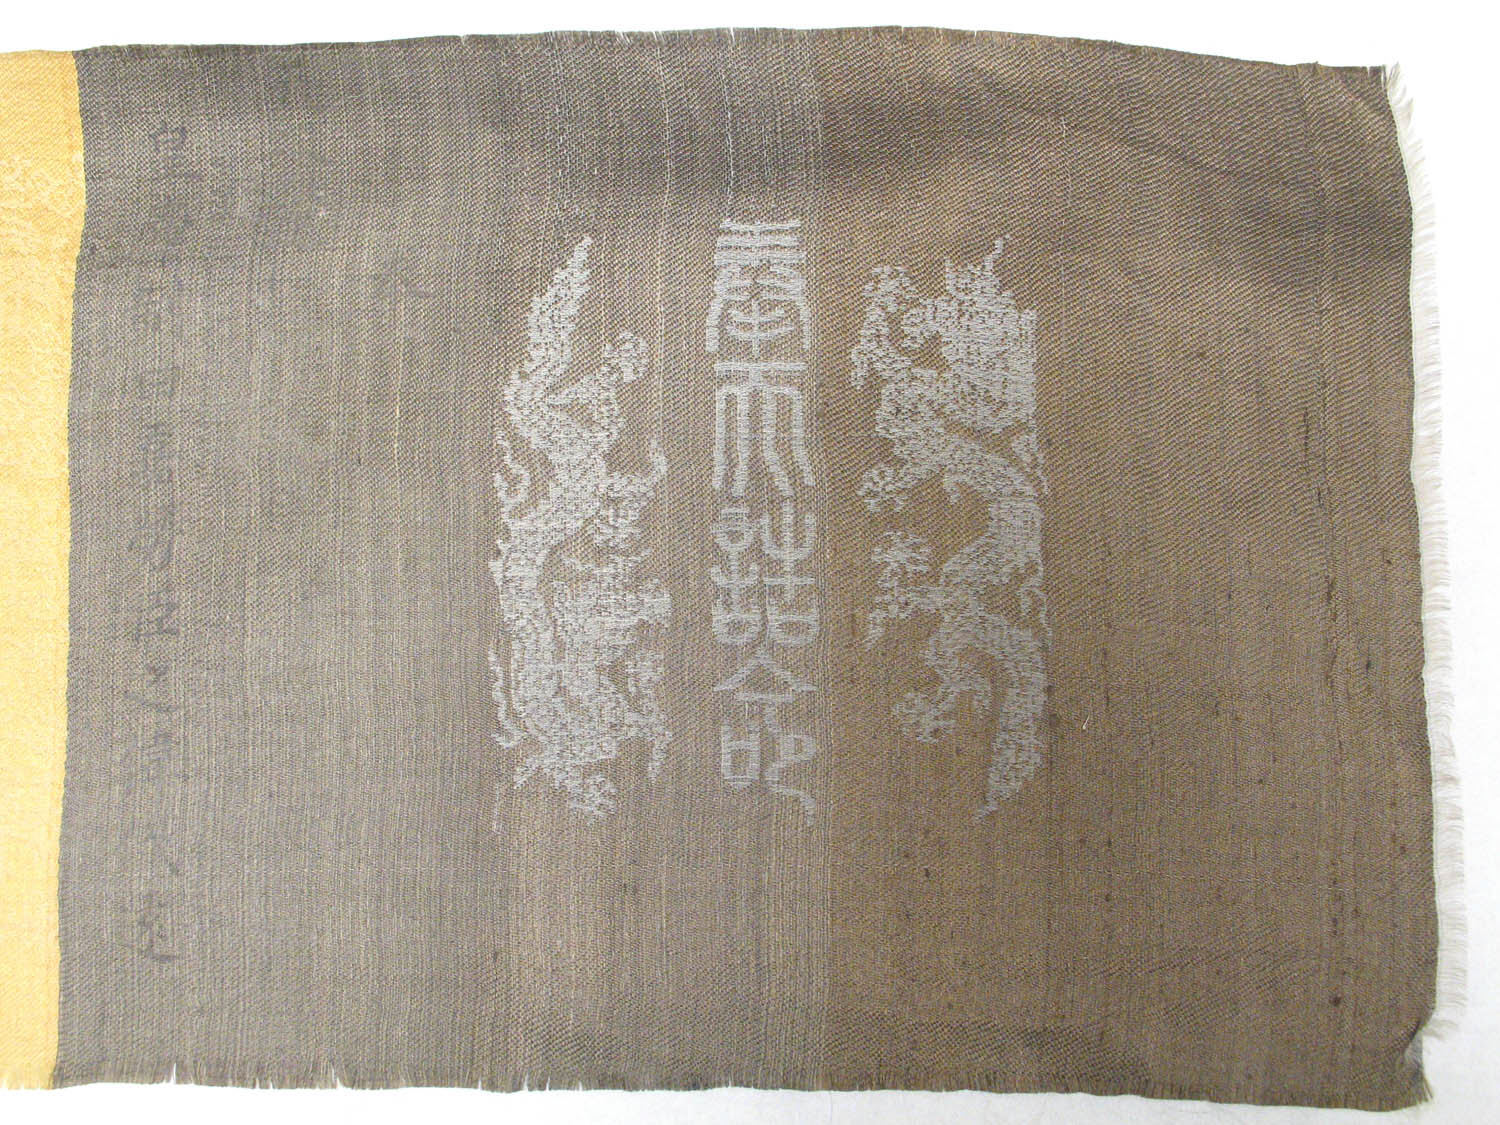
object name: textile for a handscroll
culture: chinese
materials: ink, silk